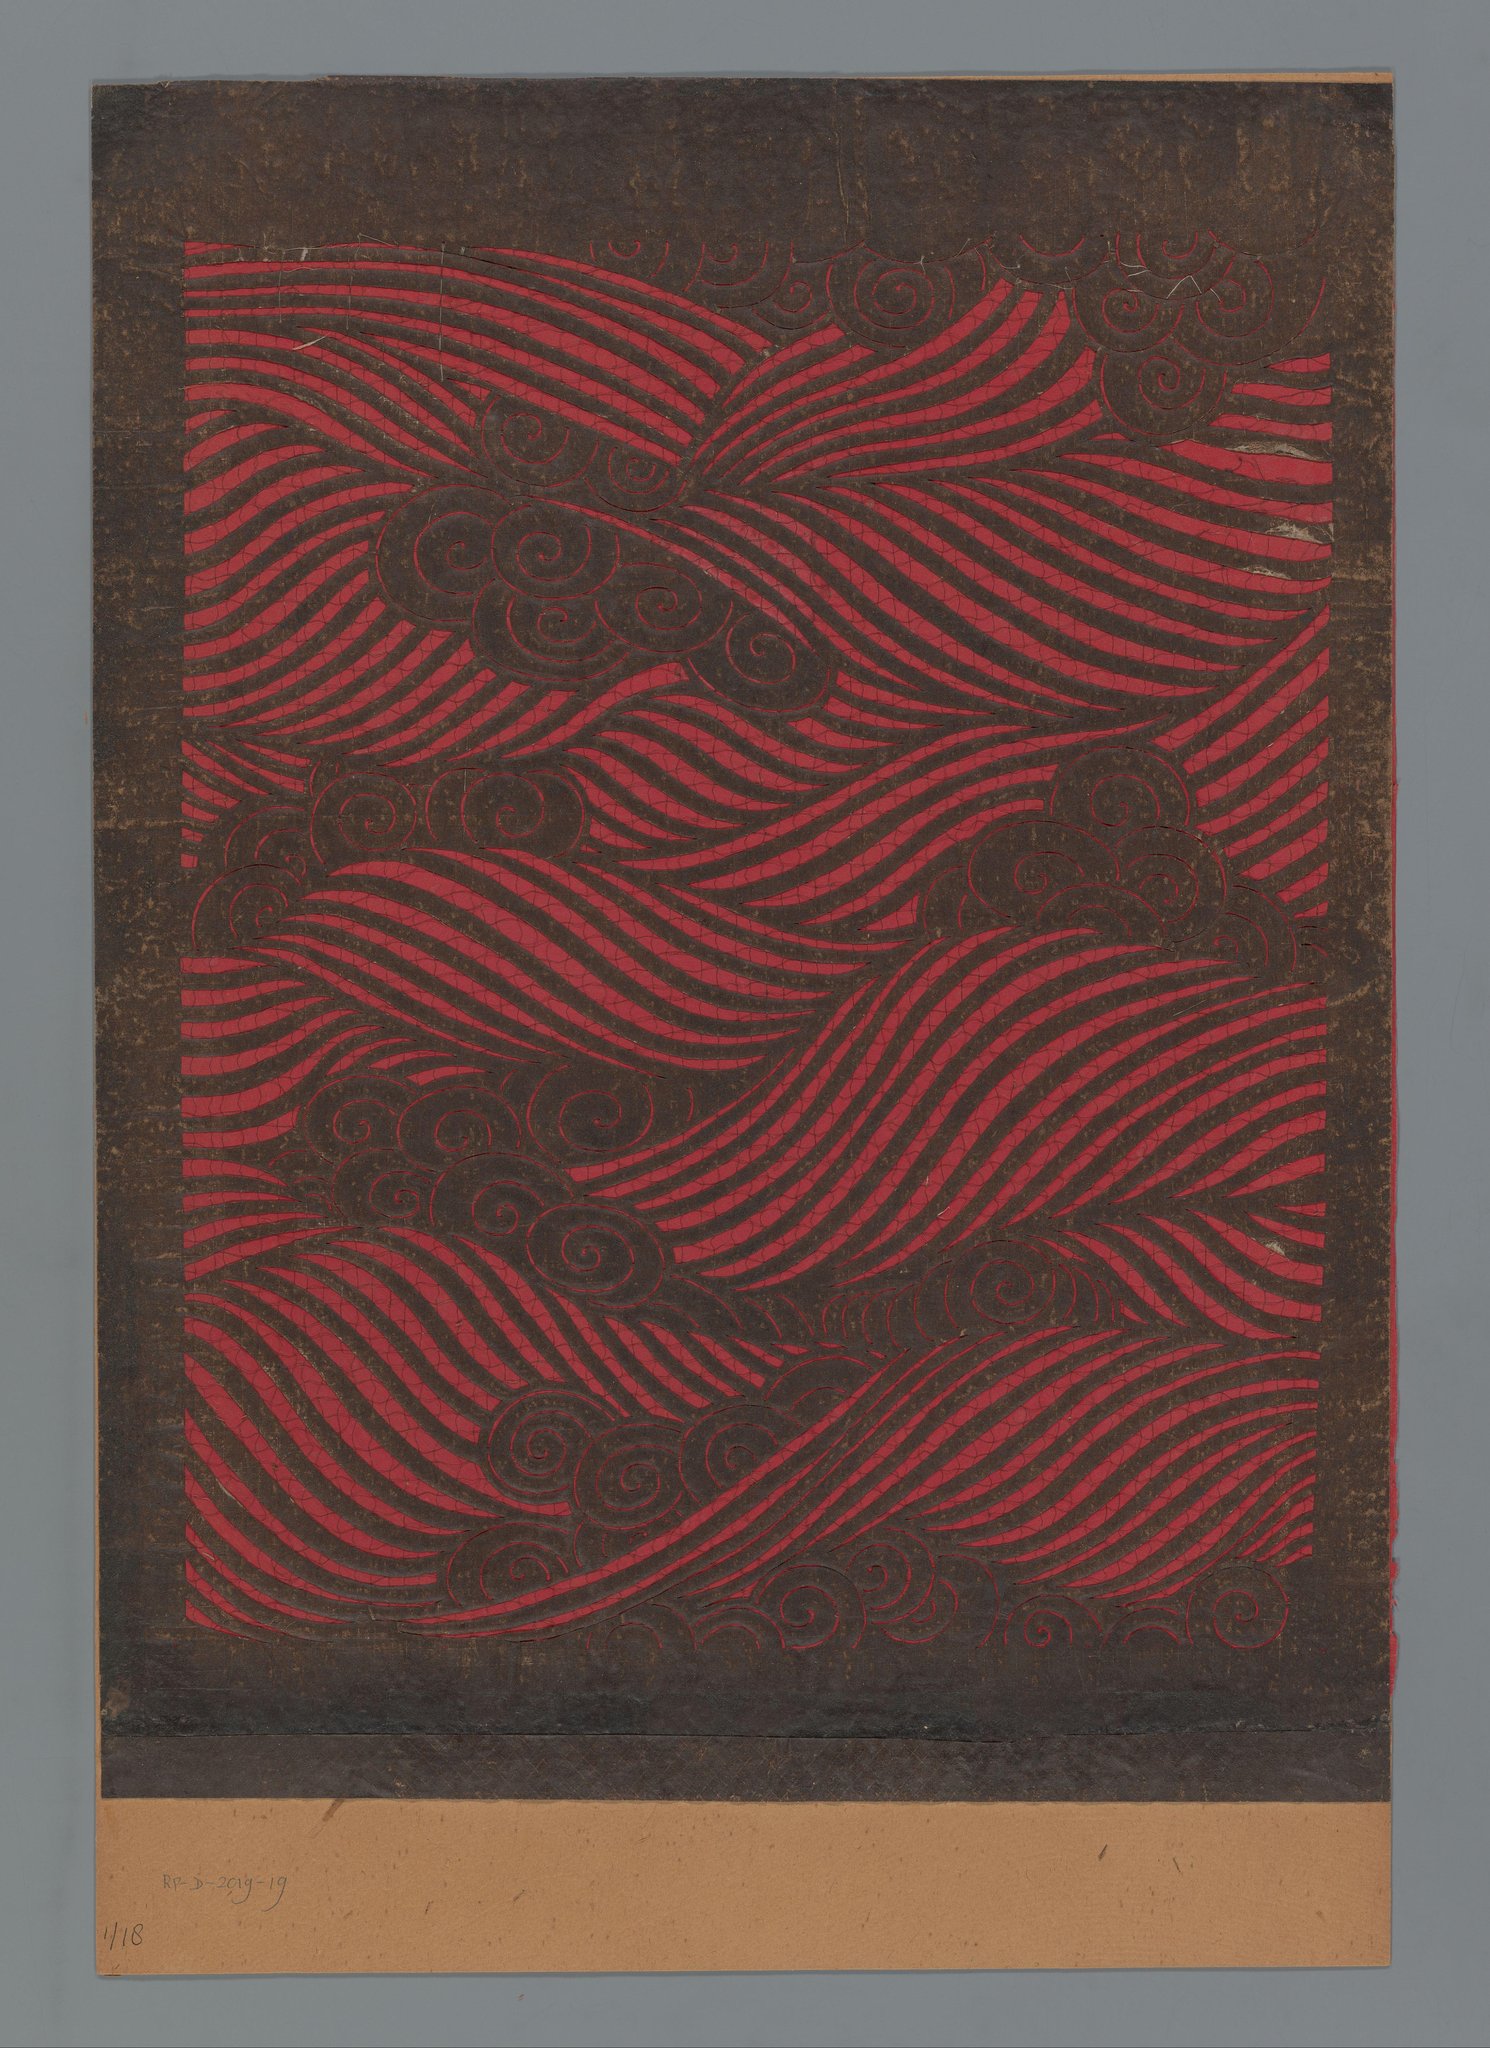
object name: katagami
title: Sjabloon met gestileerde golven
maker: Anonymous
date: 1800-1909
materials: paper, silk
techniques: cutting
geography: japan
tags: wave, ornament derived from objects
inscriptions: number: ‘1/18’, stamp: ‘Afgeschreven W...’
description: Japanse sjabloon (katagami) met een patroon van gestileerde golven en schuimkoppen.